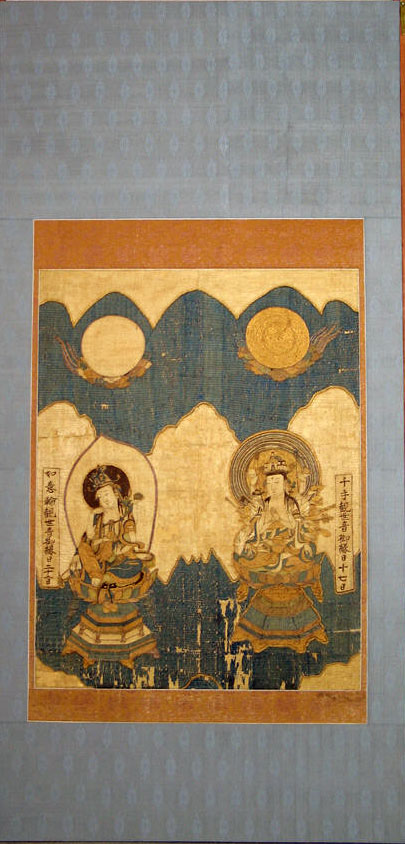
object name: panel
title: Two Bodhisattvas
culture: japanese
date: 1868-1912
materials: silk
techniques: embroidery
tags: buddhism,bodhisattvas